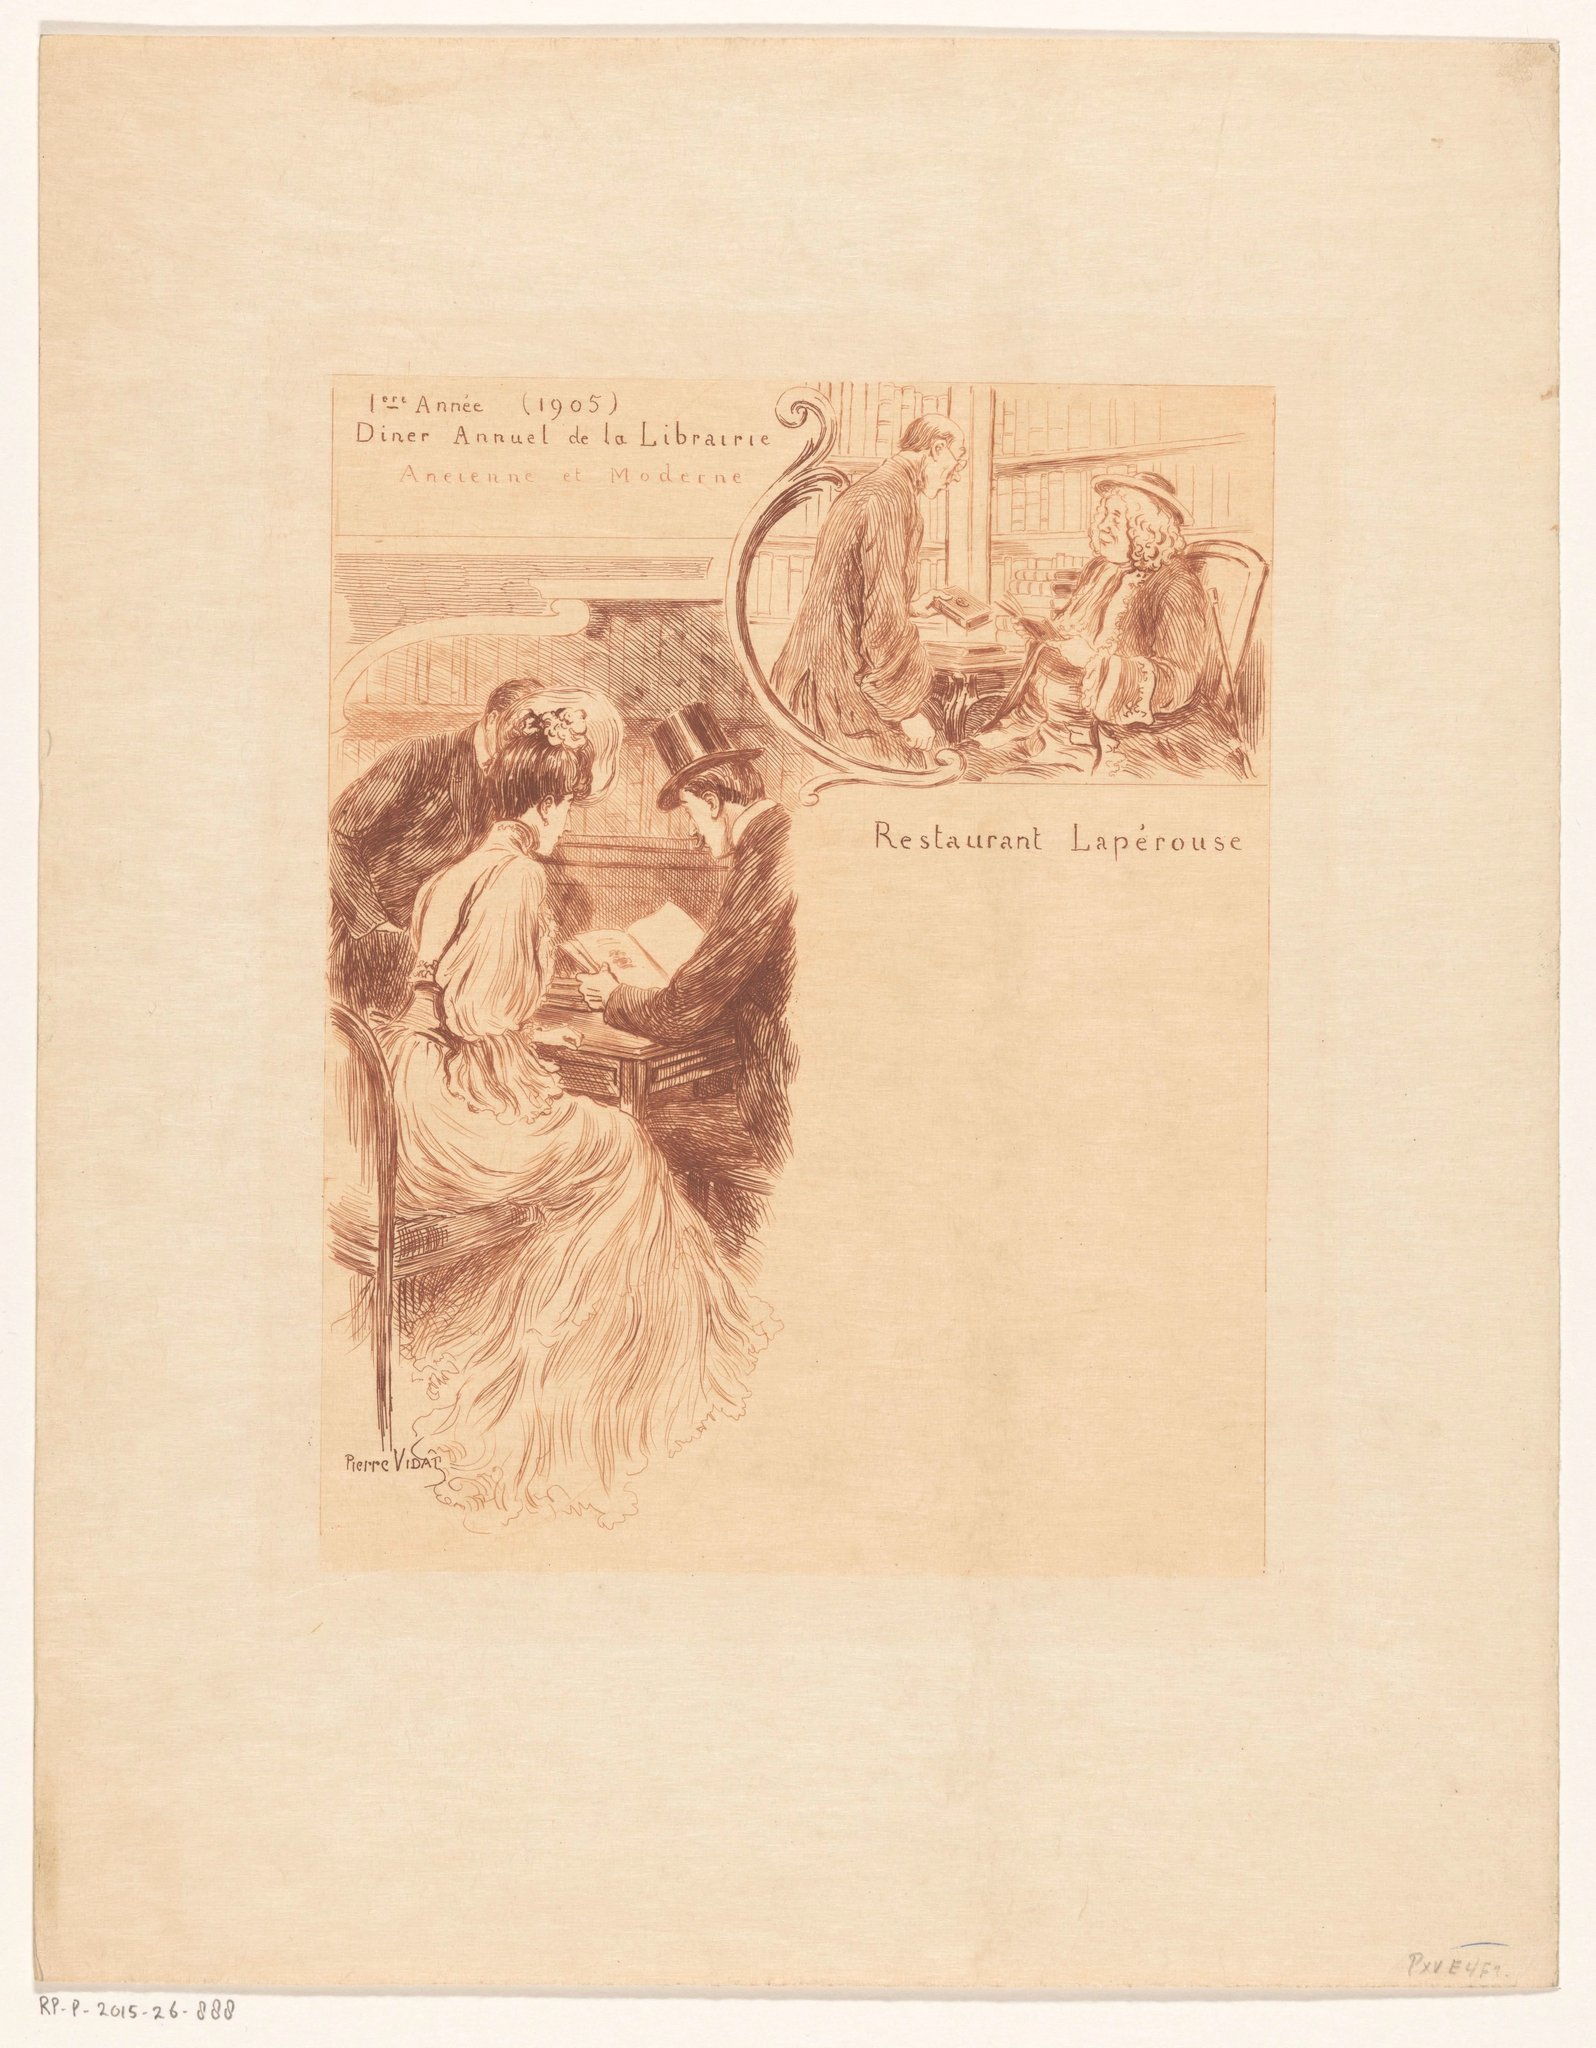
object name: print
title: Menukaart voor het jaarlijkse diner van de Librairie Ancienne et Moderne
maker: pierre vidal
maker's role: draughtsman, print maker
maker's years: 1849-1929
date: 1905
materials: paper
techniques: drypoint, etching, intaglio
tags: book, book-shop, bookseller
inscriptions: collector's mark: Lugt 2228, collector's mark: Lugt 4779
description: Twee scènes op een verder niet ingevulde menukaart. Rechts een boekhandelaar die een heer in achttiende-eeuwse kleding een boek aanbiedt; links een man en een vrouw achter een tafel die een boek bekijken, naast hen de boekhandelaar.